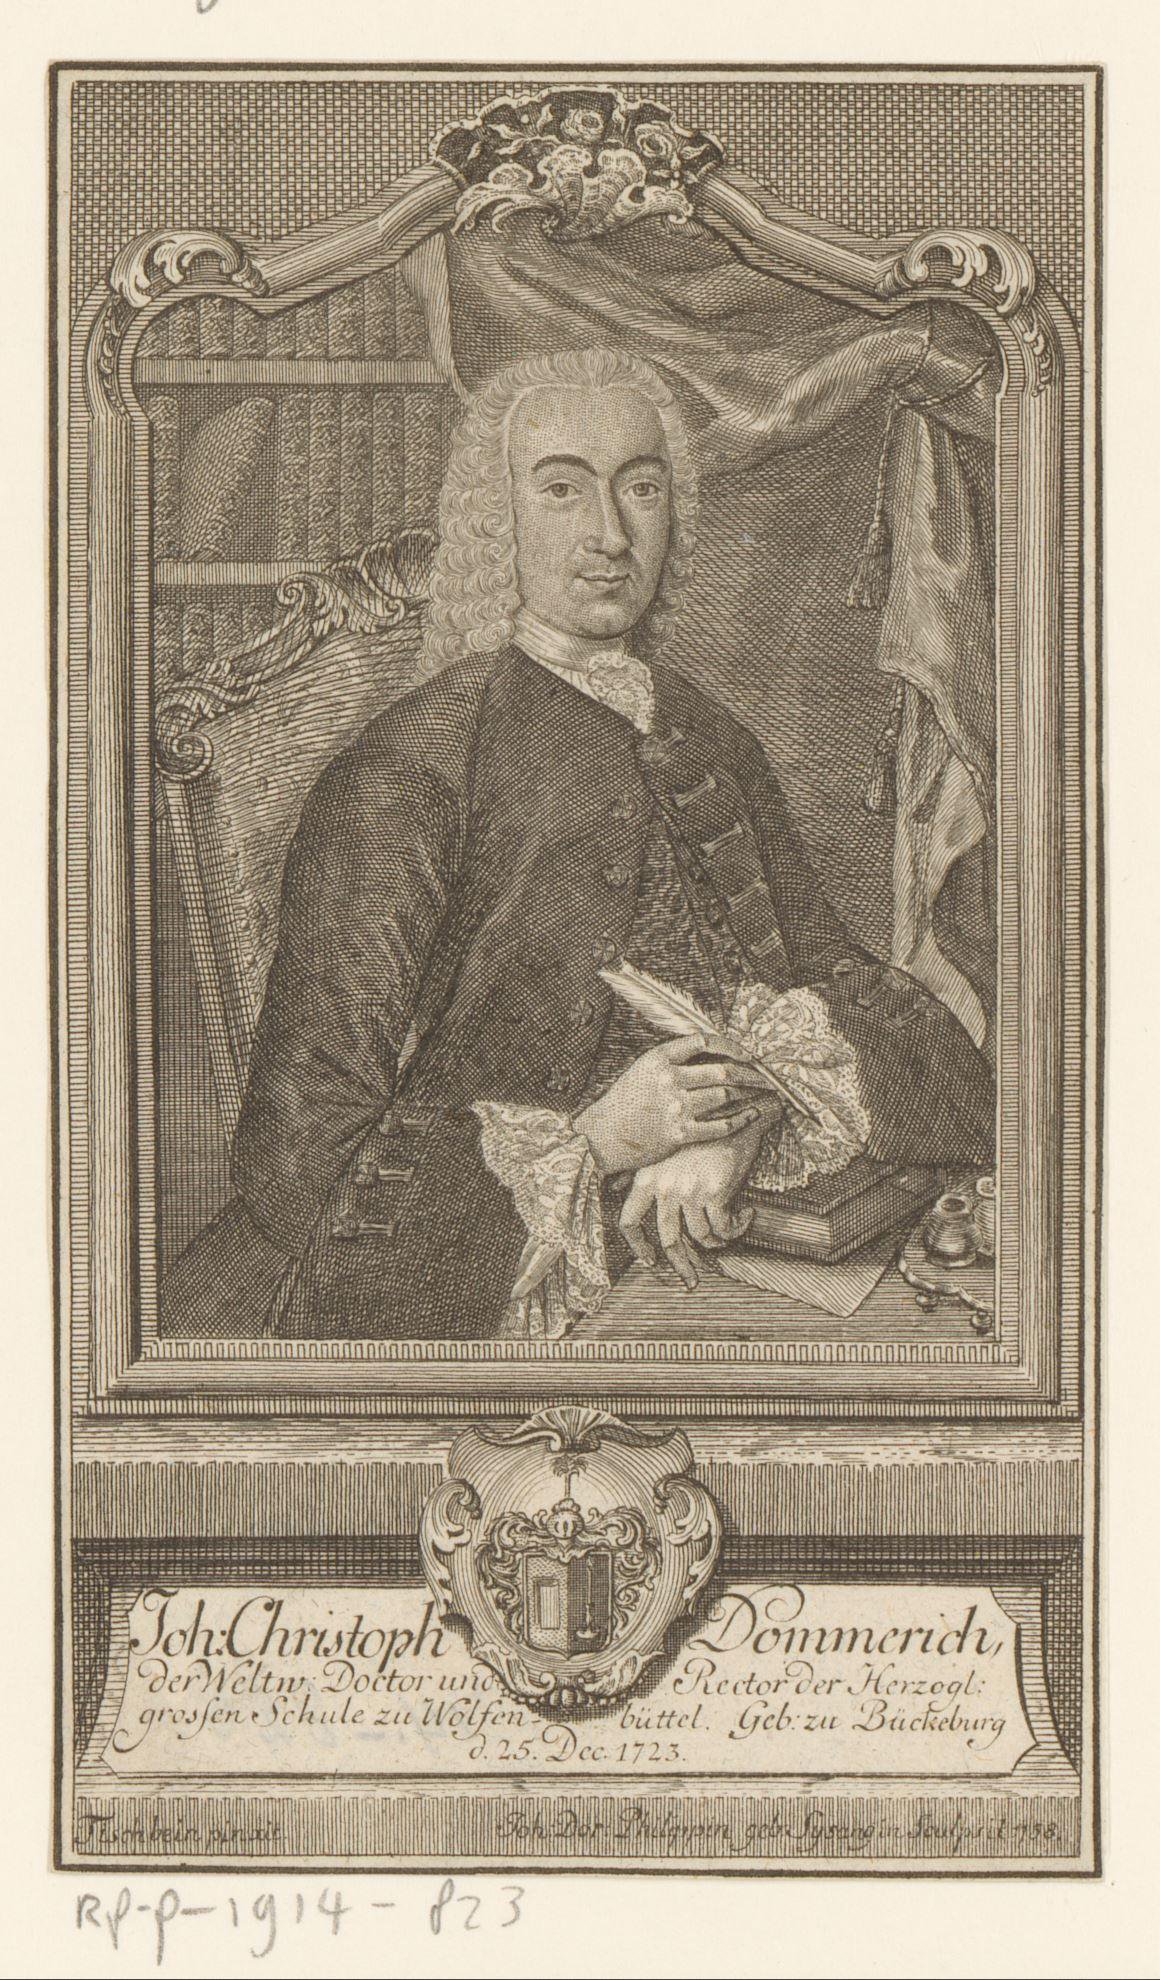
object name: print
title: Portret van Johann Christoph Dommerich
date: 1739-1791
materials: paper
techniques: engraving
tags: bookshelves, historical persons, writing accessories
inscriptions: collector's mark: Lugt 2228